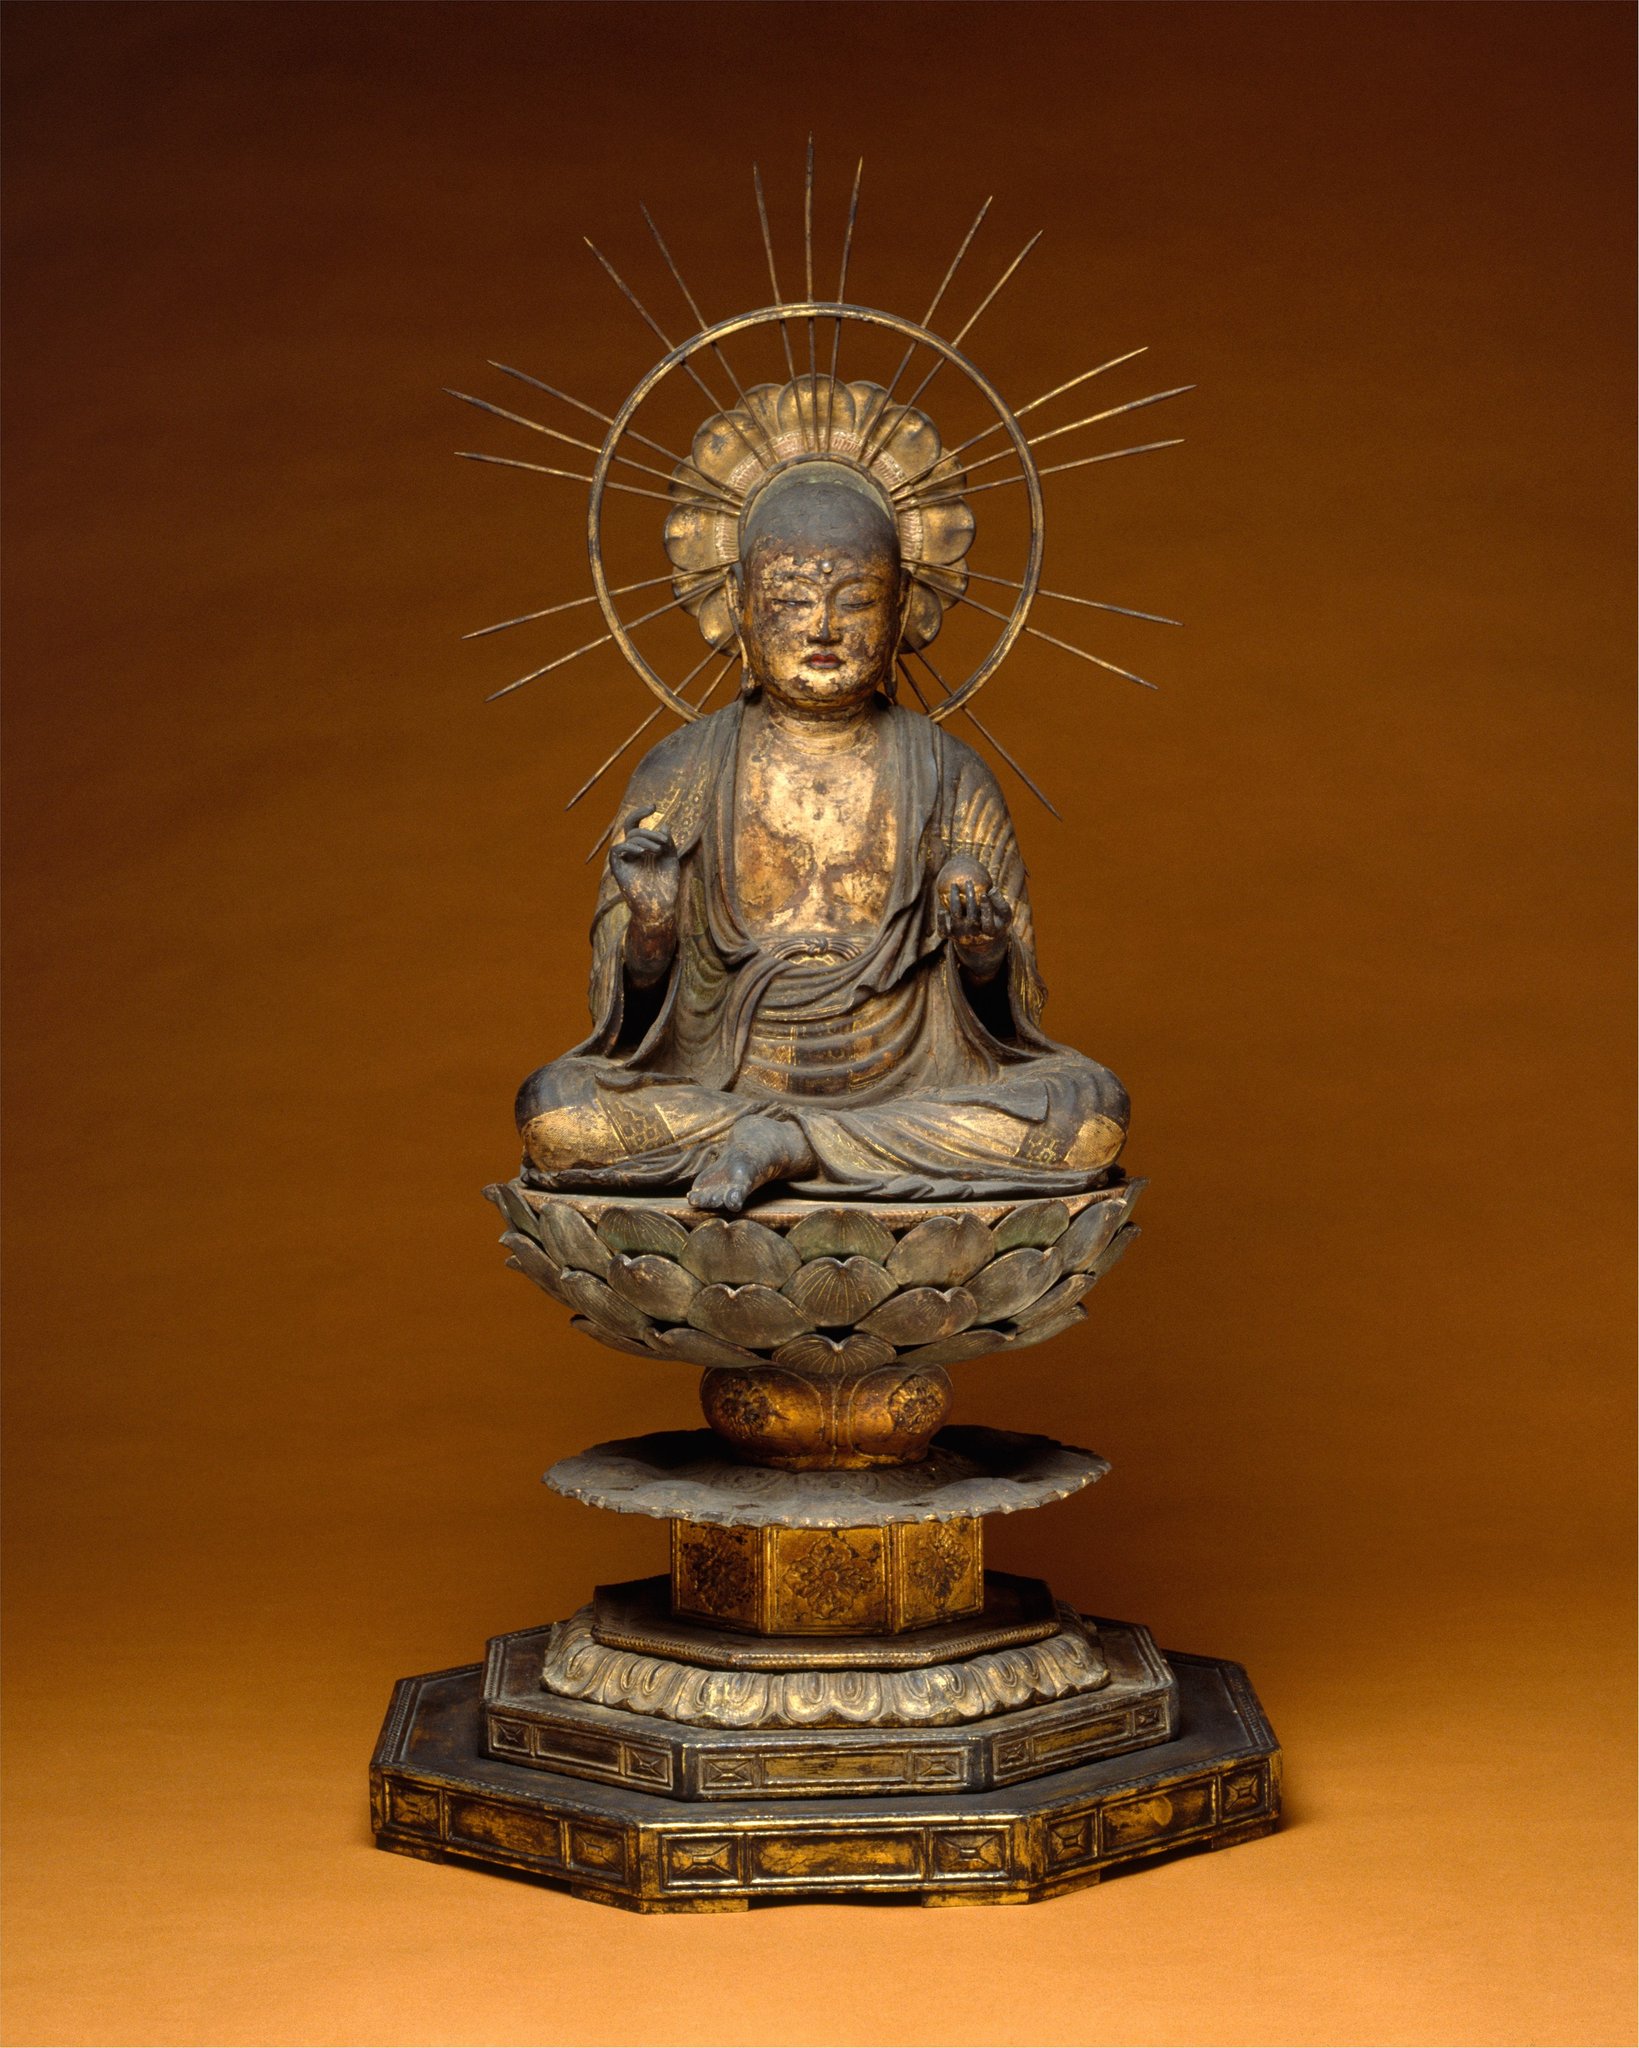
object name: figure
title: Jizō, Bodhisattva of the Earth Store (Kshitigarbha)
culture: japanese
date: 1251-1300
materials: gold, lacquer, pigment, wood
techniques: cutting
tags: buddhism,bodhisattvas